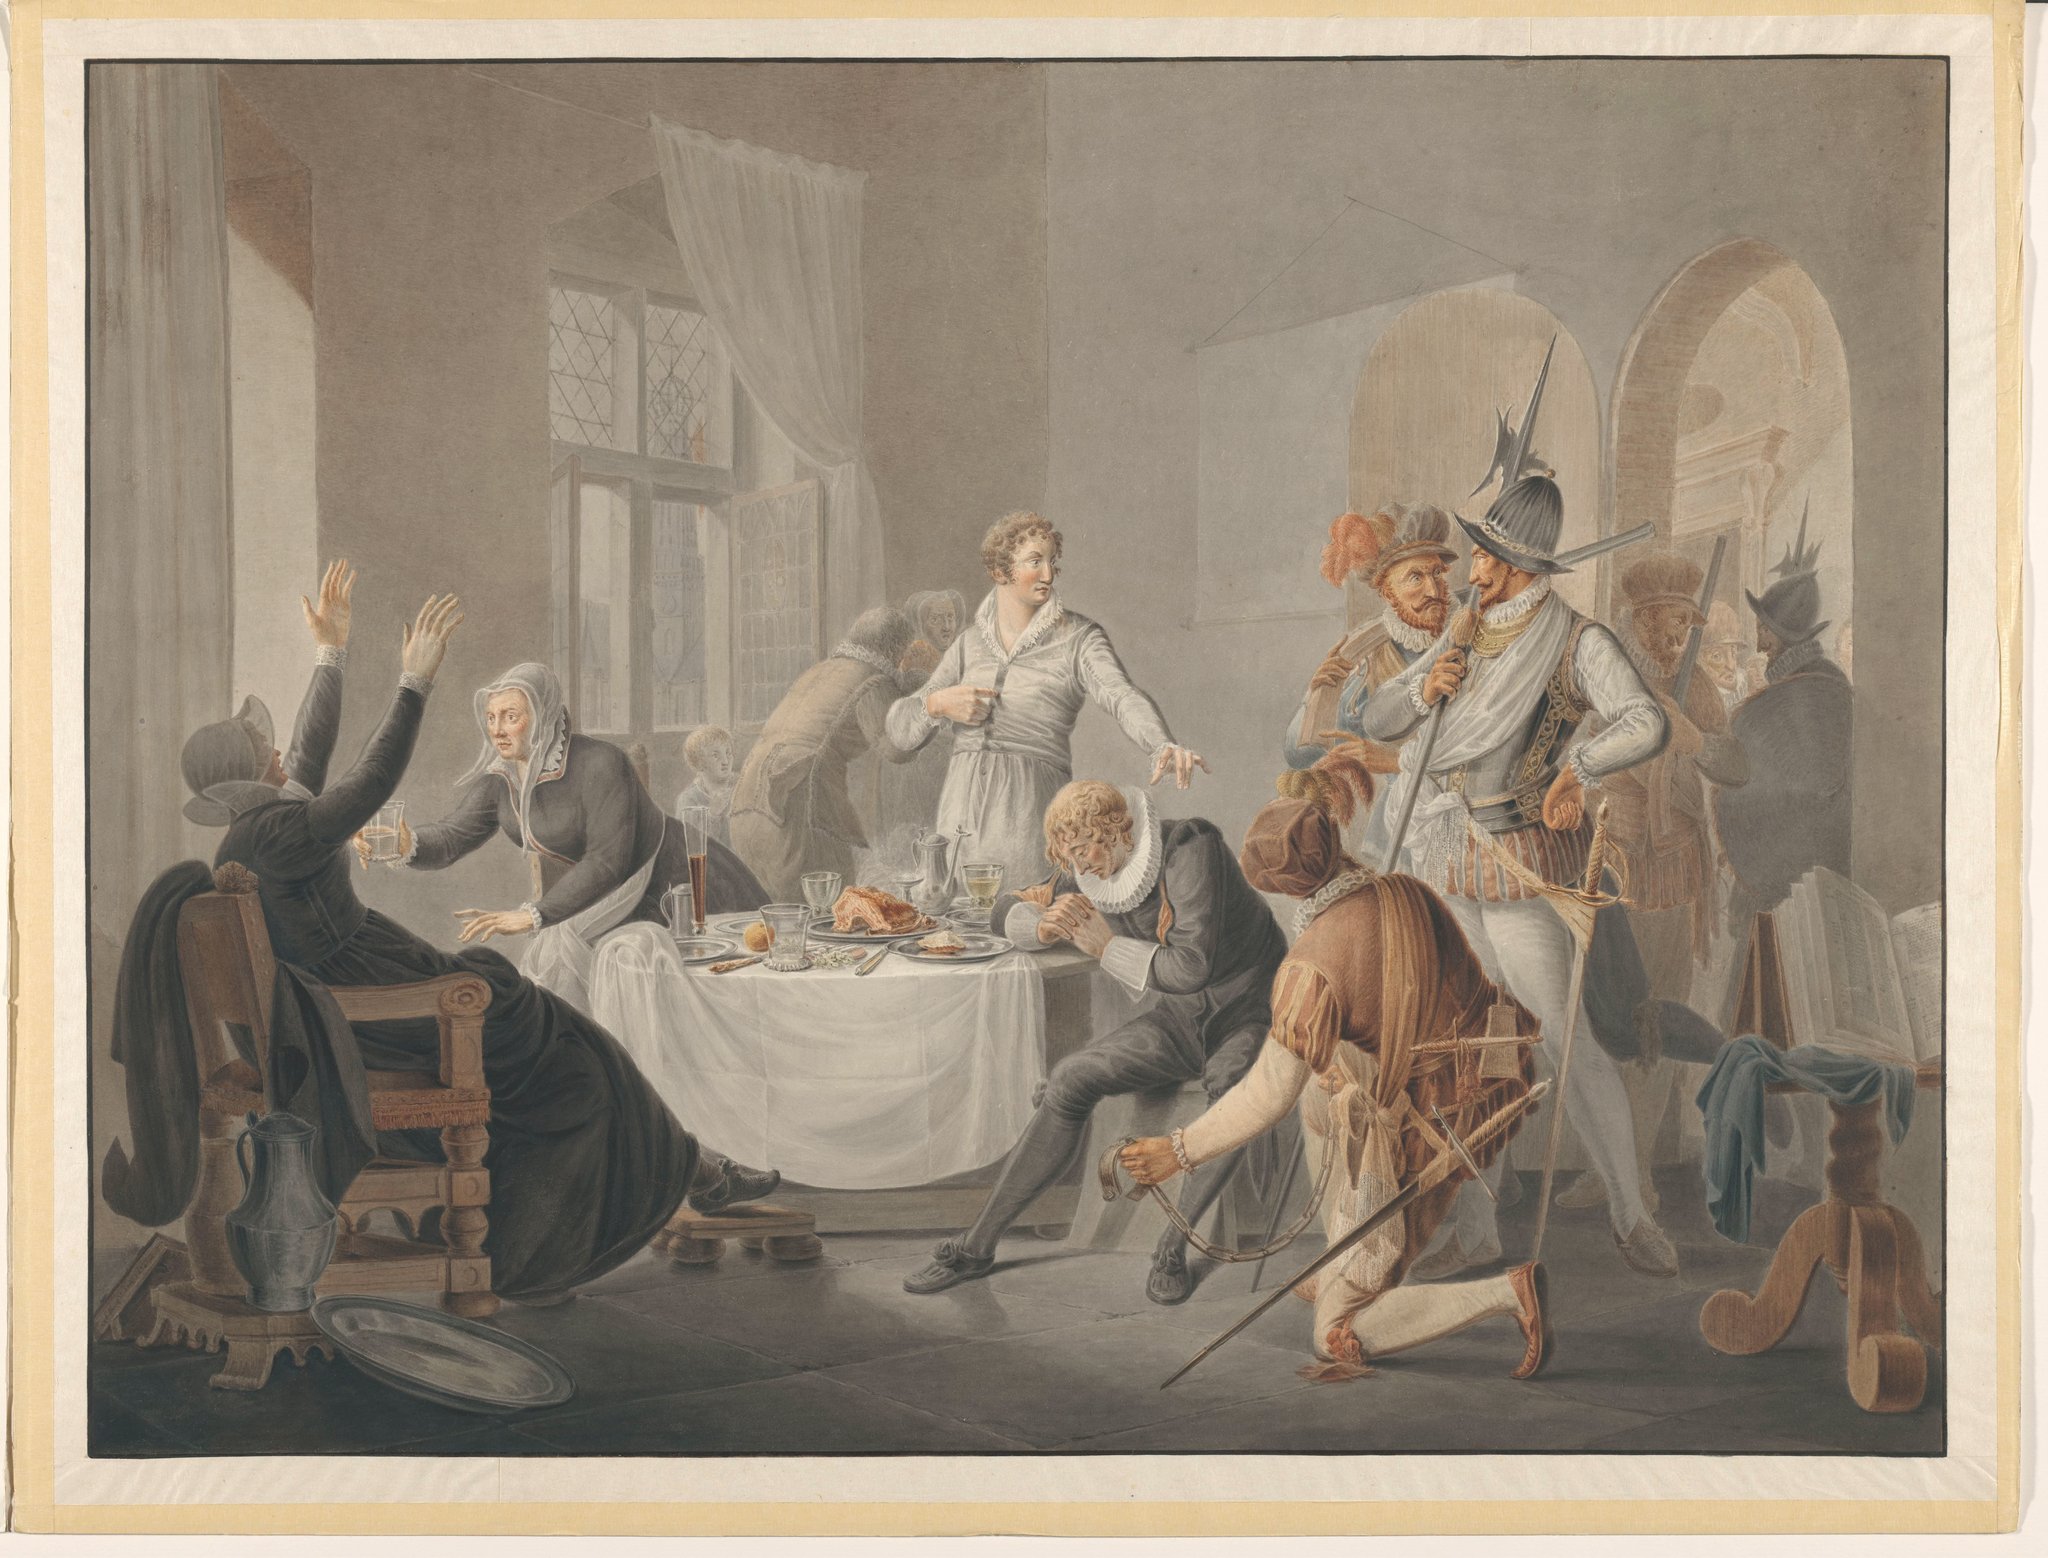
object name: watercolor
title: P.D. Hasselaer maakt zich bekend, toen de Spanjaarden zijn broer Claes Dirkz. in zijn plaats gevangen wilden nemen.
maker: pieter bartholomeusz. barbiers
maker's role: draughtsman, print maker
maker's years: 1772-1837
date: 1809-1810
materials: paper, watercolor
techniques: brush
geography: netherlands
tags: arrest (of criminal), netherlands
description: Rechts komen Spaanse soldaten door een deur binnen, waarvan er één reeds knielt om boeien om de enkels van een zittende man (Claes Dirkz.) te slaan. Vlak naast hem is P.D. Hasselaer echter al opgestaan en wijst zichzelf de borst. Links en op de achtergrond de vrouwen en familieleden in paniek. De familie zat aan een gedekte tafel.